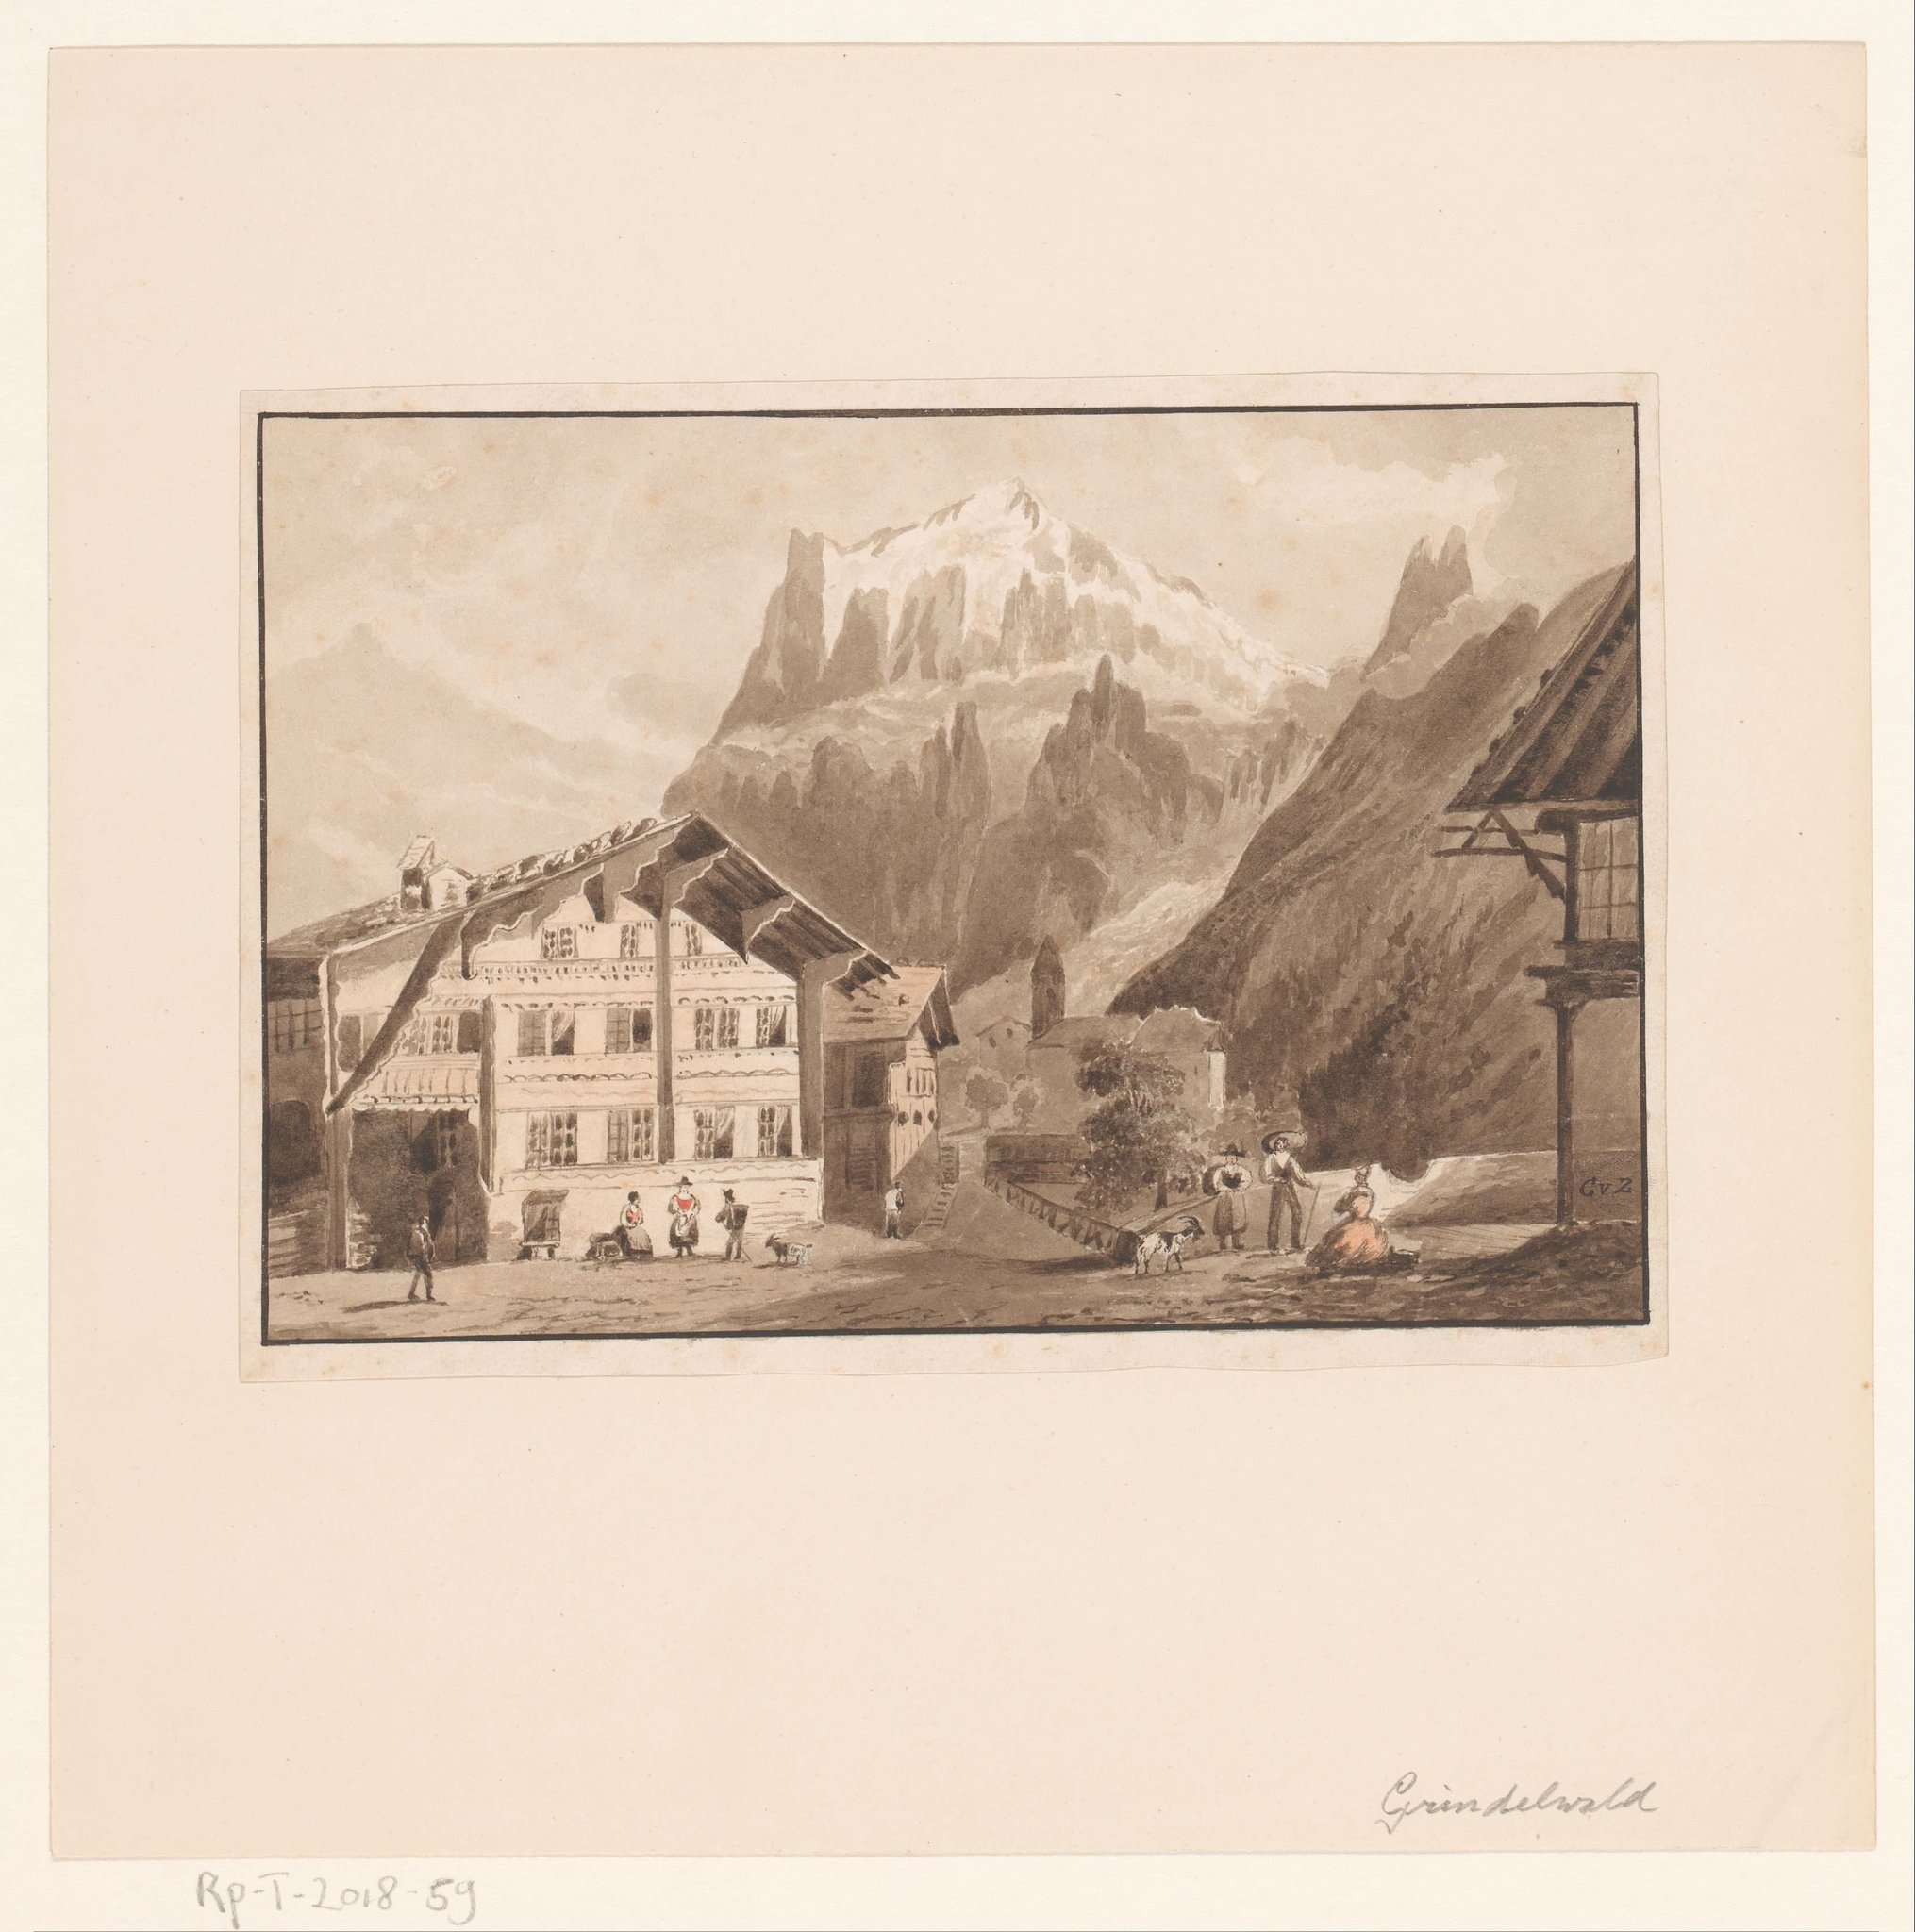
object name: drawing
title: Gezicht op het dorp Grindelwald met in de verte een gletsjer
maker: monogrammist gvz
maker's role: draughtsman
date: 1800-1899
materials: ink, paper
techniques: brush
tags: prospect of village, silhouette of village, glacier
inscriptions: collector's mark: Lugt 2228